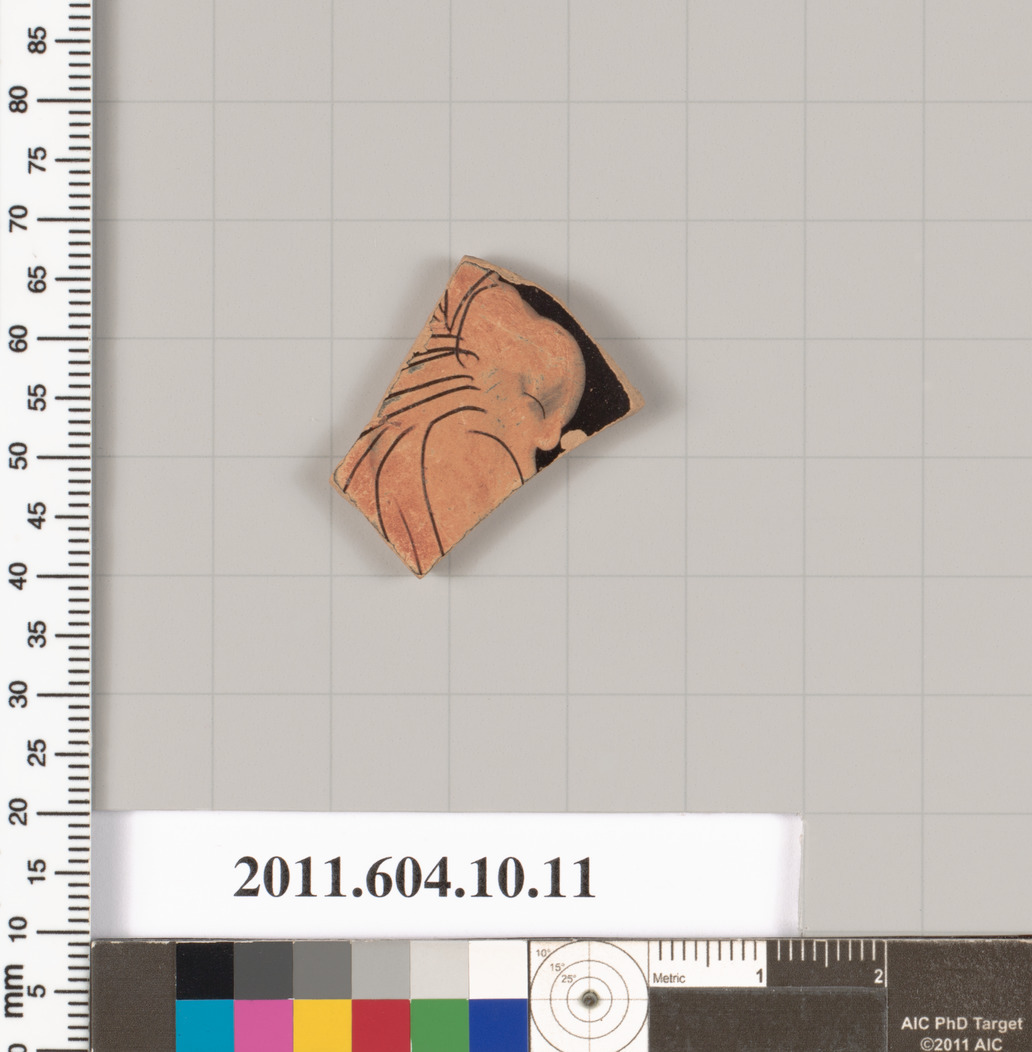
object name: kylix fragment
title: Terracotta fragment of a stemless kylix (drinking cup)?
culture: etruscan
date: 434-368 BCE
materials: terracotta